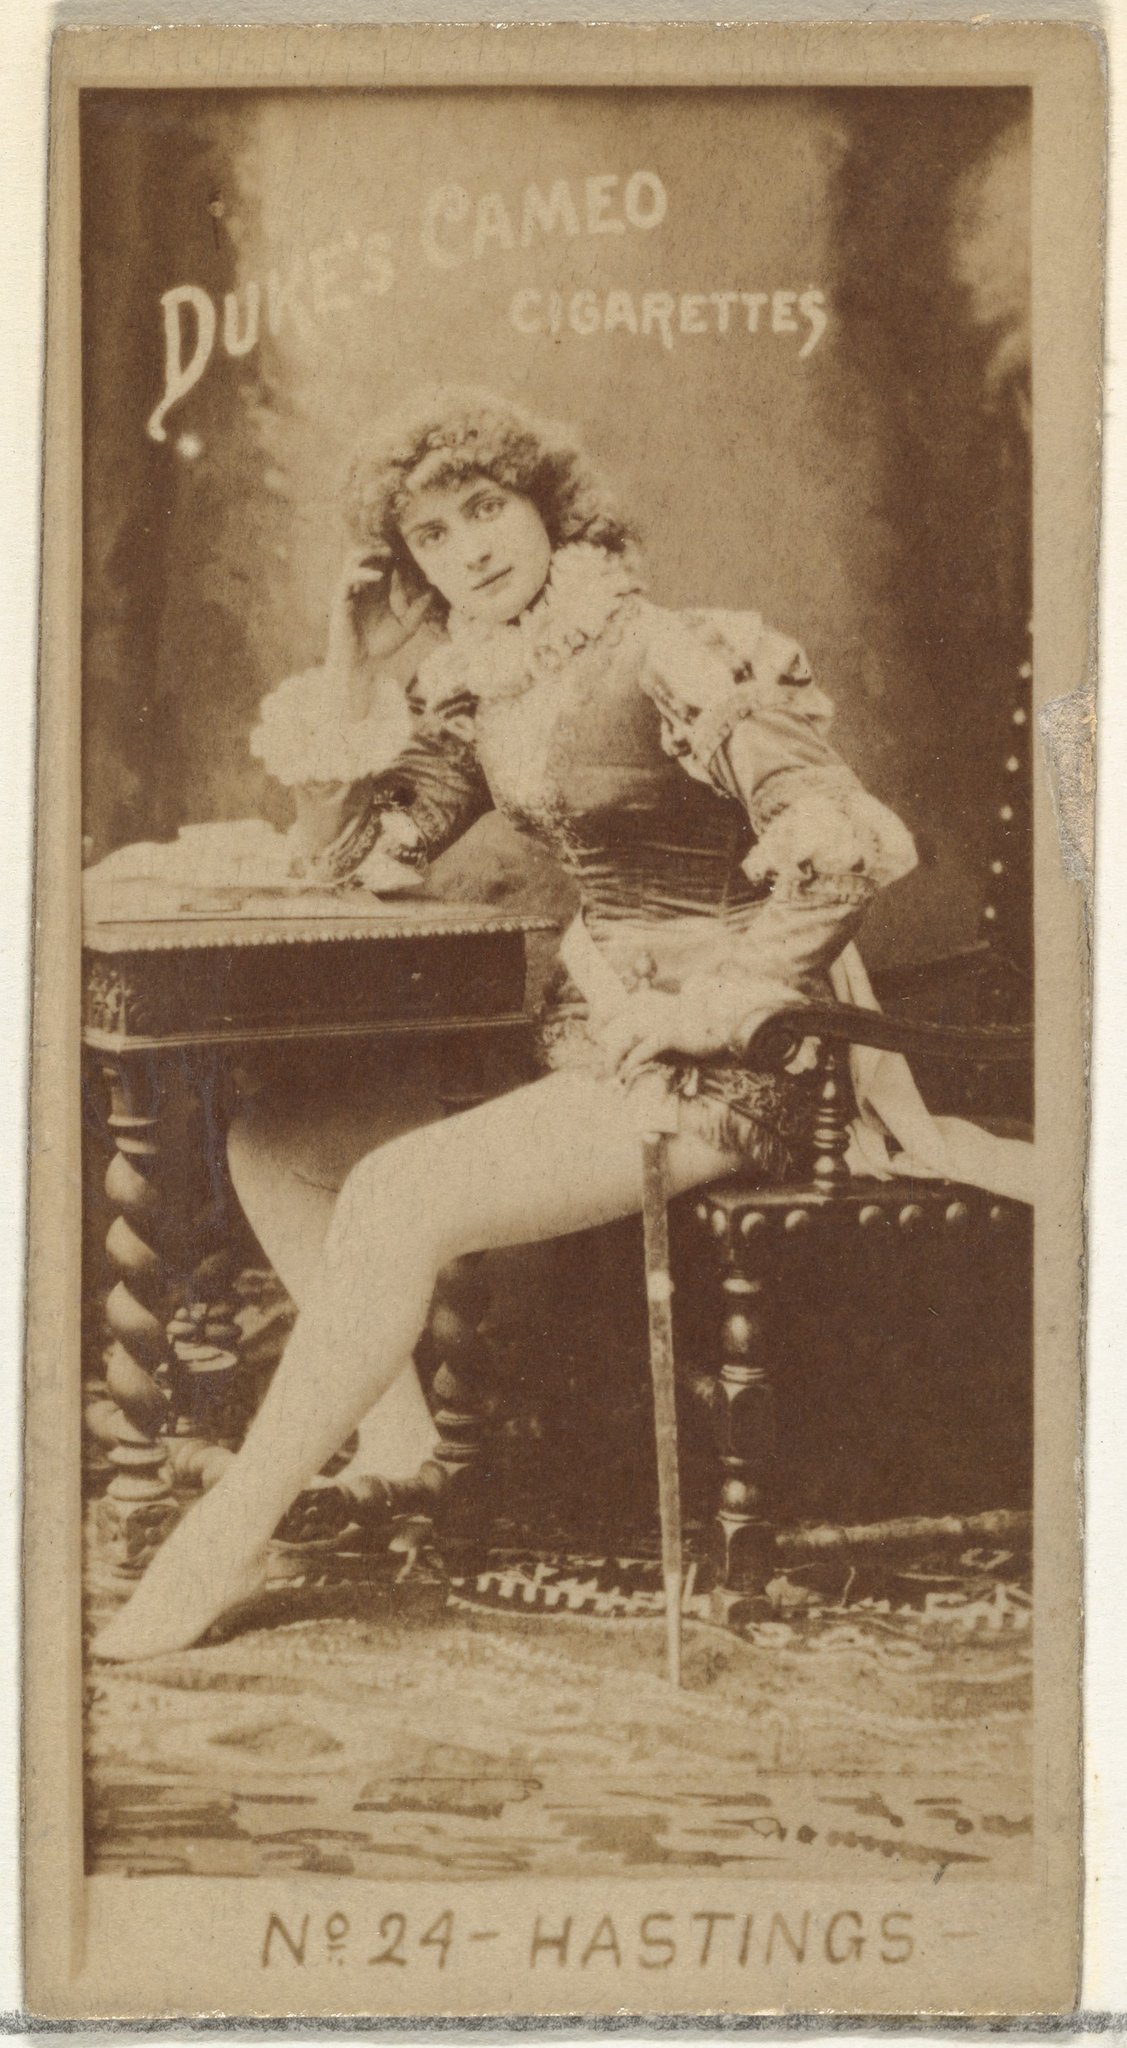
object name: photograph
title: Card Number 24, Hastings, from the Actors and Actresses series (N145-4) issued by Duke Sons & Co. to promote Cameo Cigarettes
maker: w. duke, sons & co.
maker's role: publisher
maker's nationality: american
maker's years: 1870-1920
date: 1880-1889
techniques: albumen silver print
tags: portraits,women,actresses